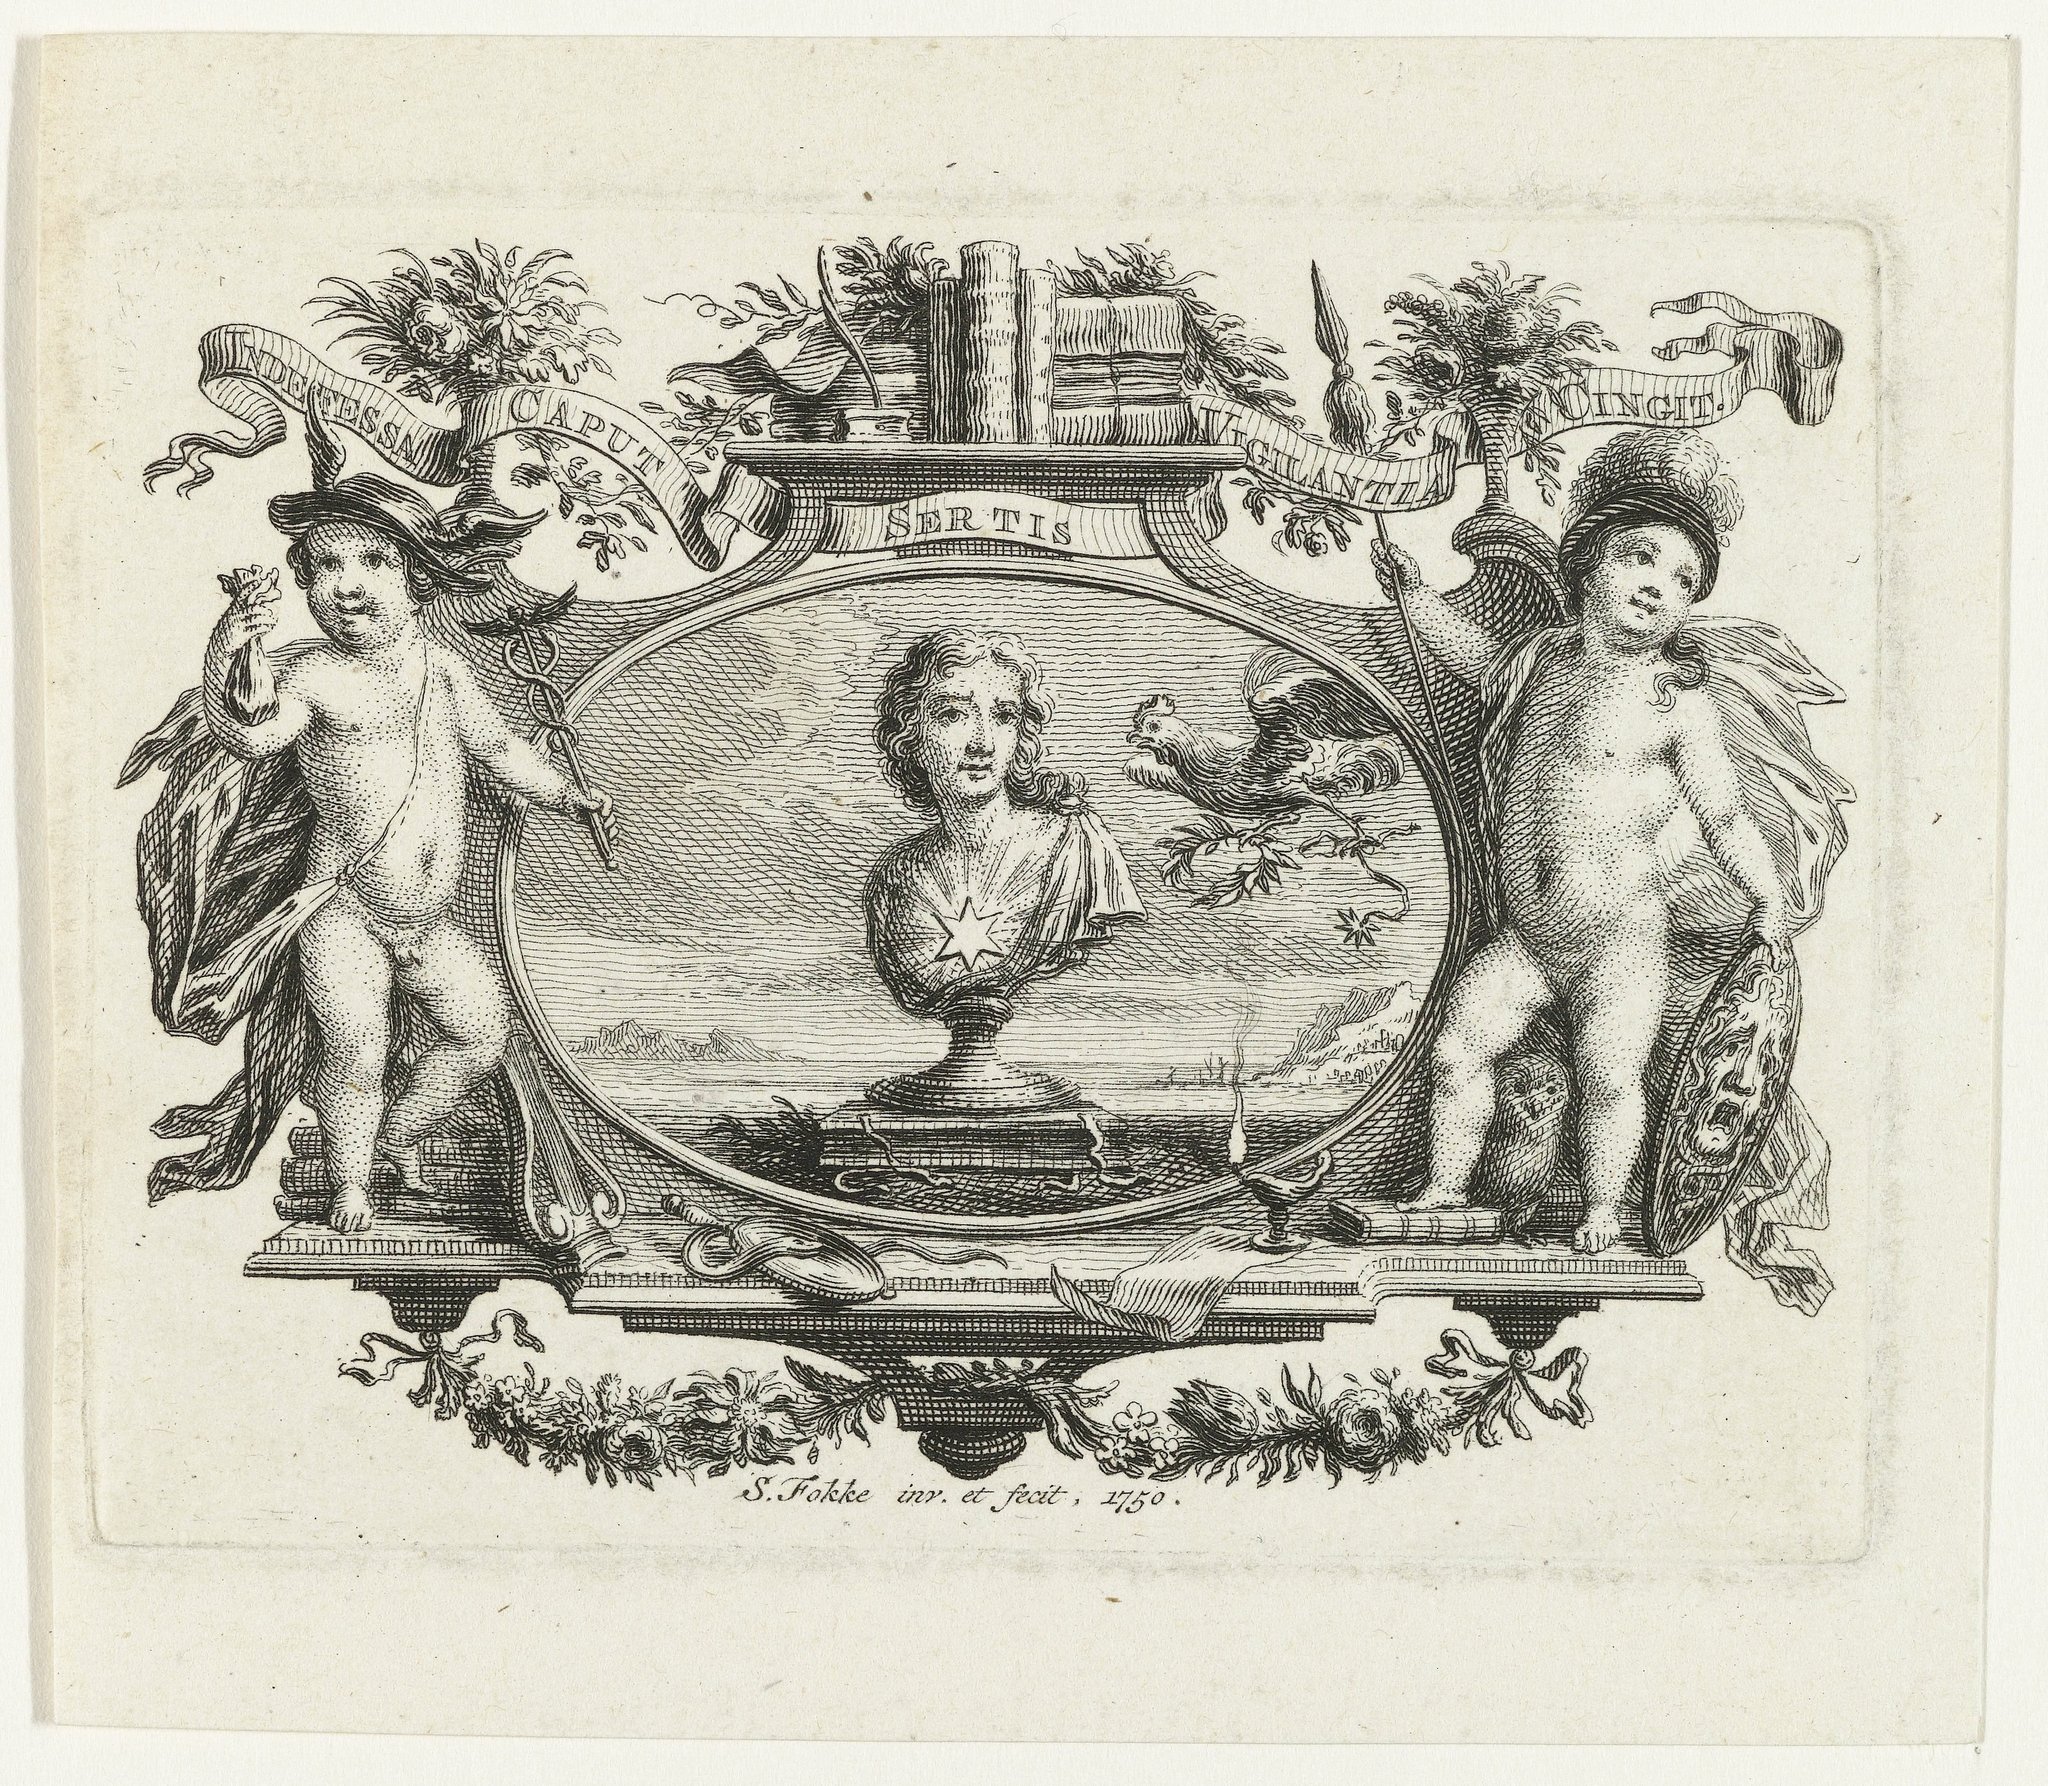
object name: print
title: Cartouche met vrouwenbuste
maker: simon fokke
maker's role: draughtsman, print maker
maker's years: 1712-1784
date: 1750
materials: paper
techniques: etching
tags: historical persons not known by name (+ (full) bust portrait)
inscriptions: collector's mark: Lugt 2228, collector's mark: Lugt 2760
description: In een cartouche staat binnen een ovaal een gebeeldhouwde vrouwenbuste met een zespuntige ster op haar borst. Een haan vliegt met een lauwerkrans en een ster tussen zijn klauwen op de buste af. Het ovaal wordt geflankeerd door twee putti die verkleed zijn als Mercurius en Minerva, onderaan liggen een spiegel, een slang en een olielamp. Bovenop de cartouche staat een plank met boeken en een banderol met de woorden: Indefessa Caput Sertis Vigilantia Cingit.